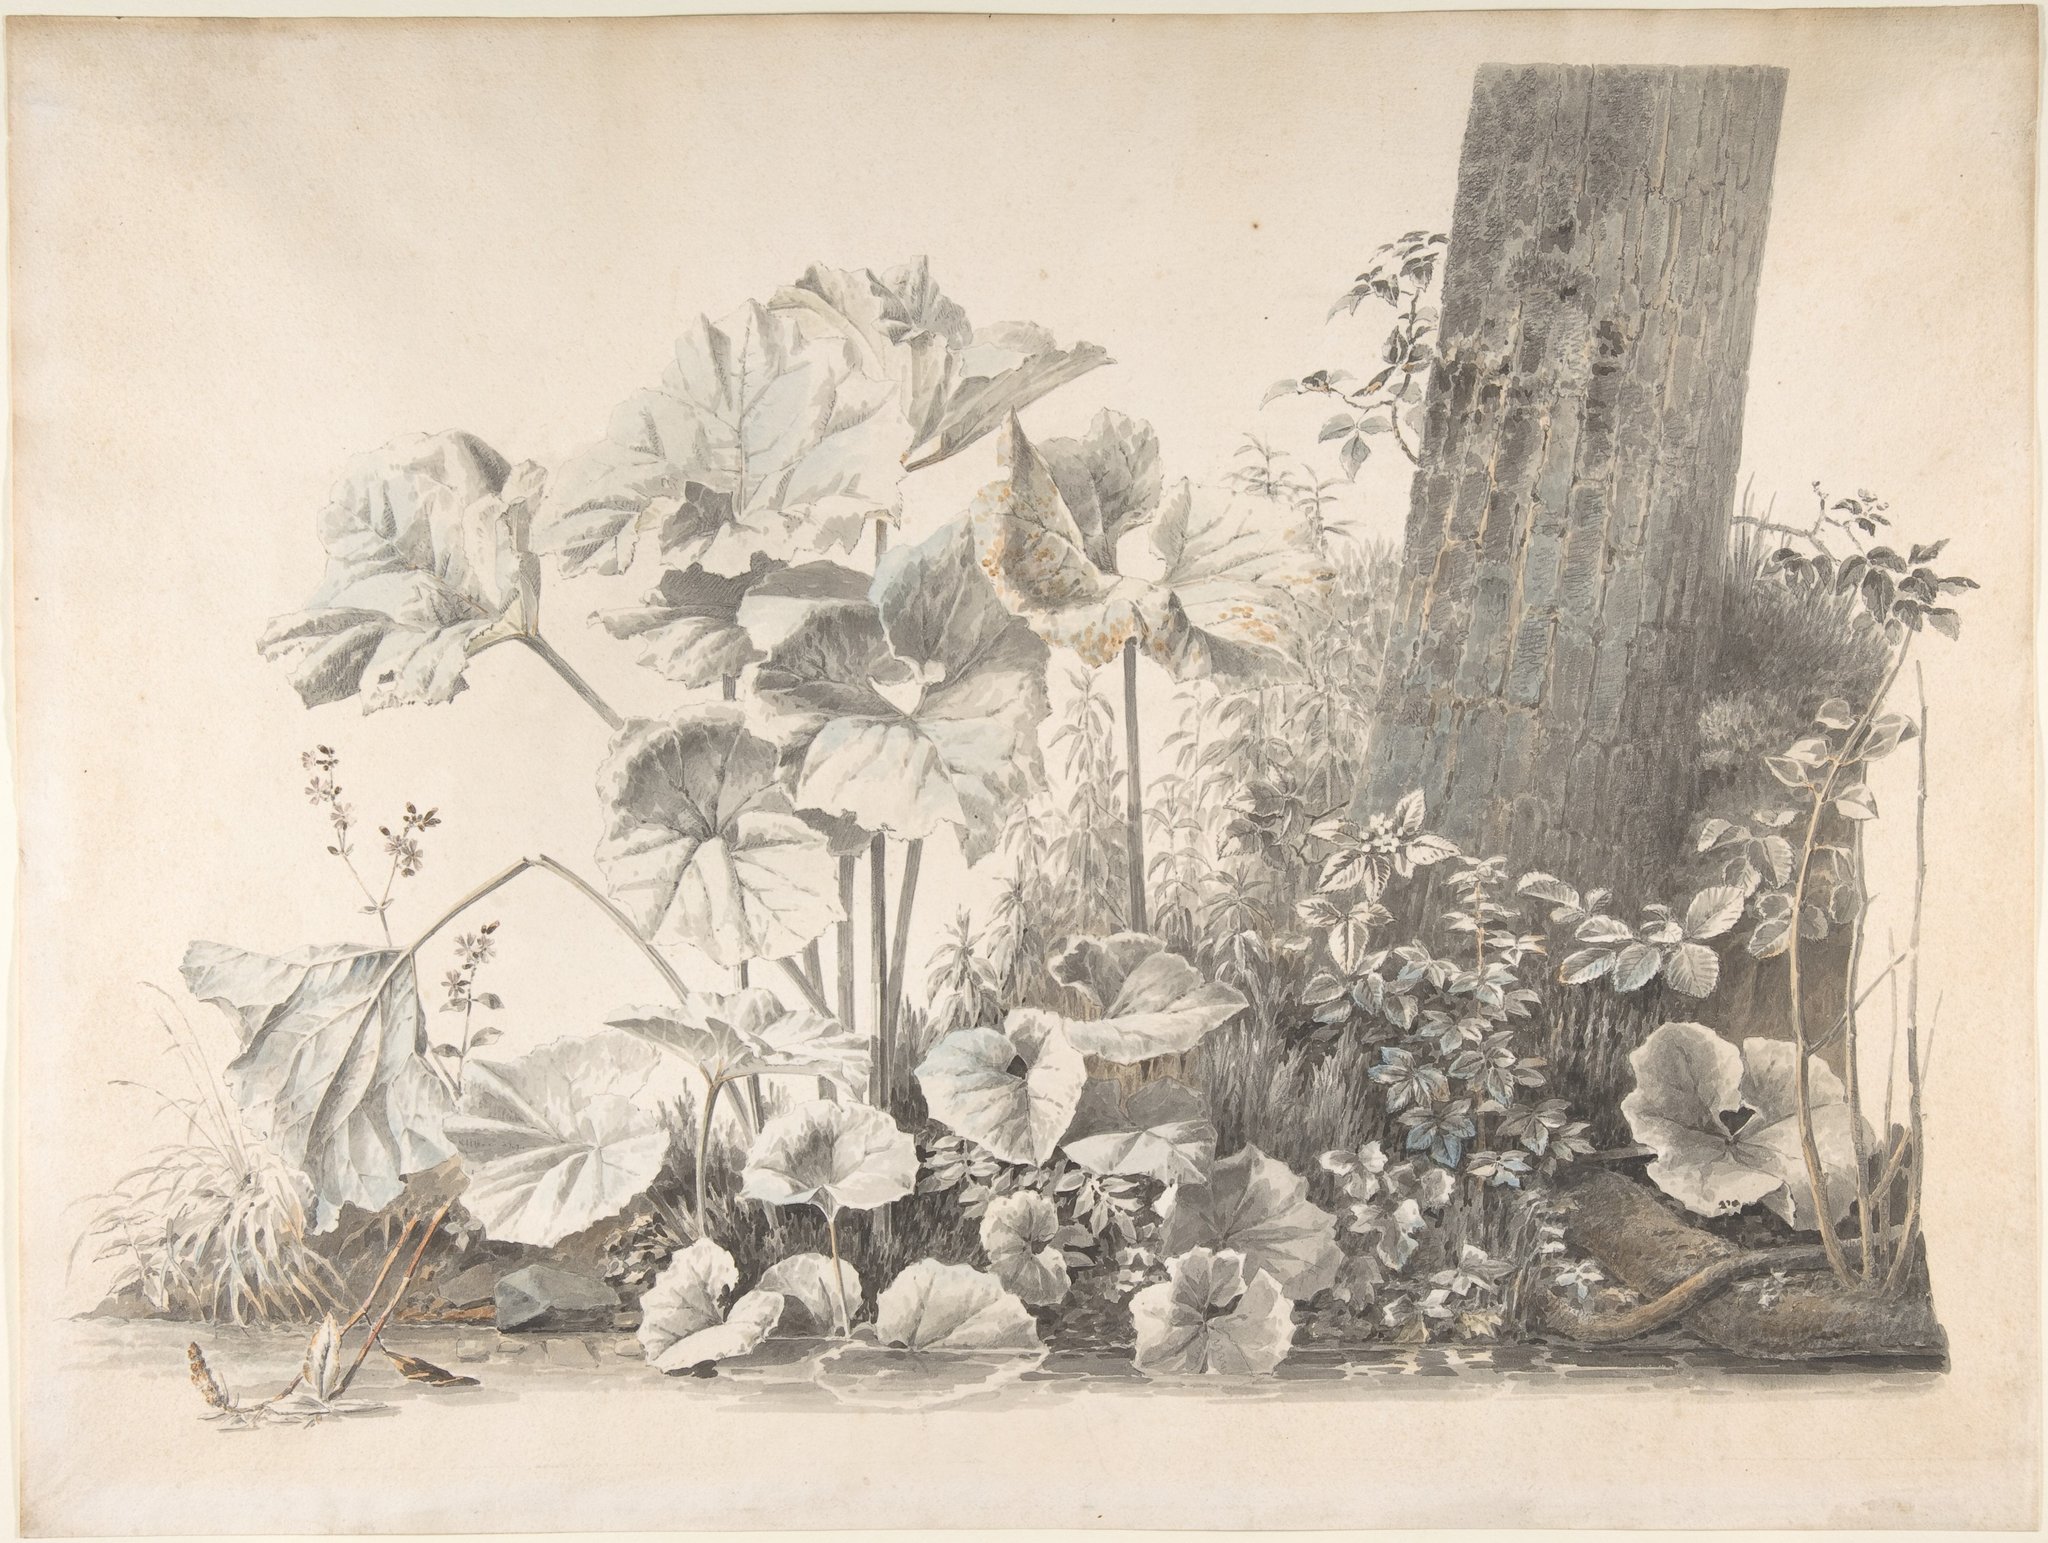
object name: drawing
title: Burdocks, Campions and Brambles by a Treetrunk on a River Bank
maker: josephus augustus knip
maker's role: artist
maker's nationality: dutch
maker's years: 1777-1847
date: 1801-1833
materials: lead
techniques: wash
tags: rivers,leaves,trees